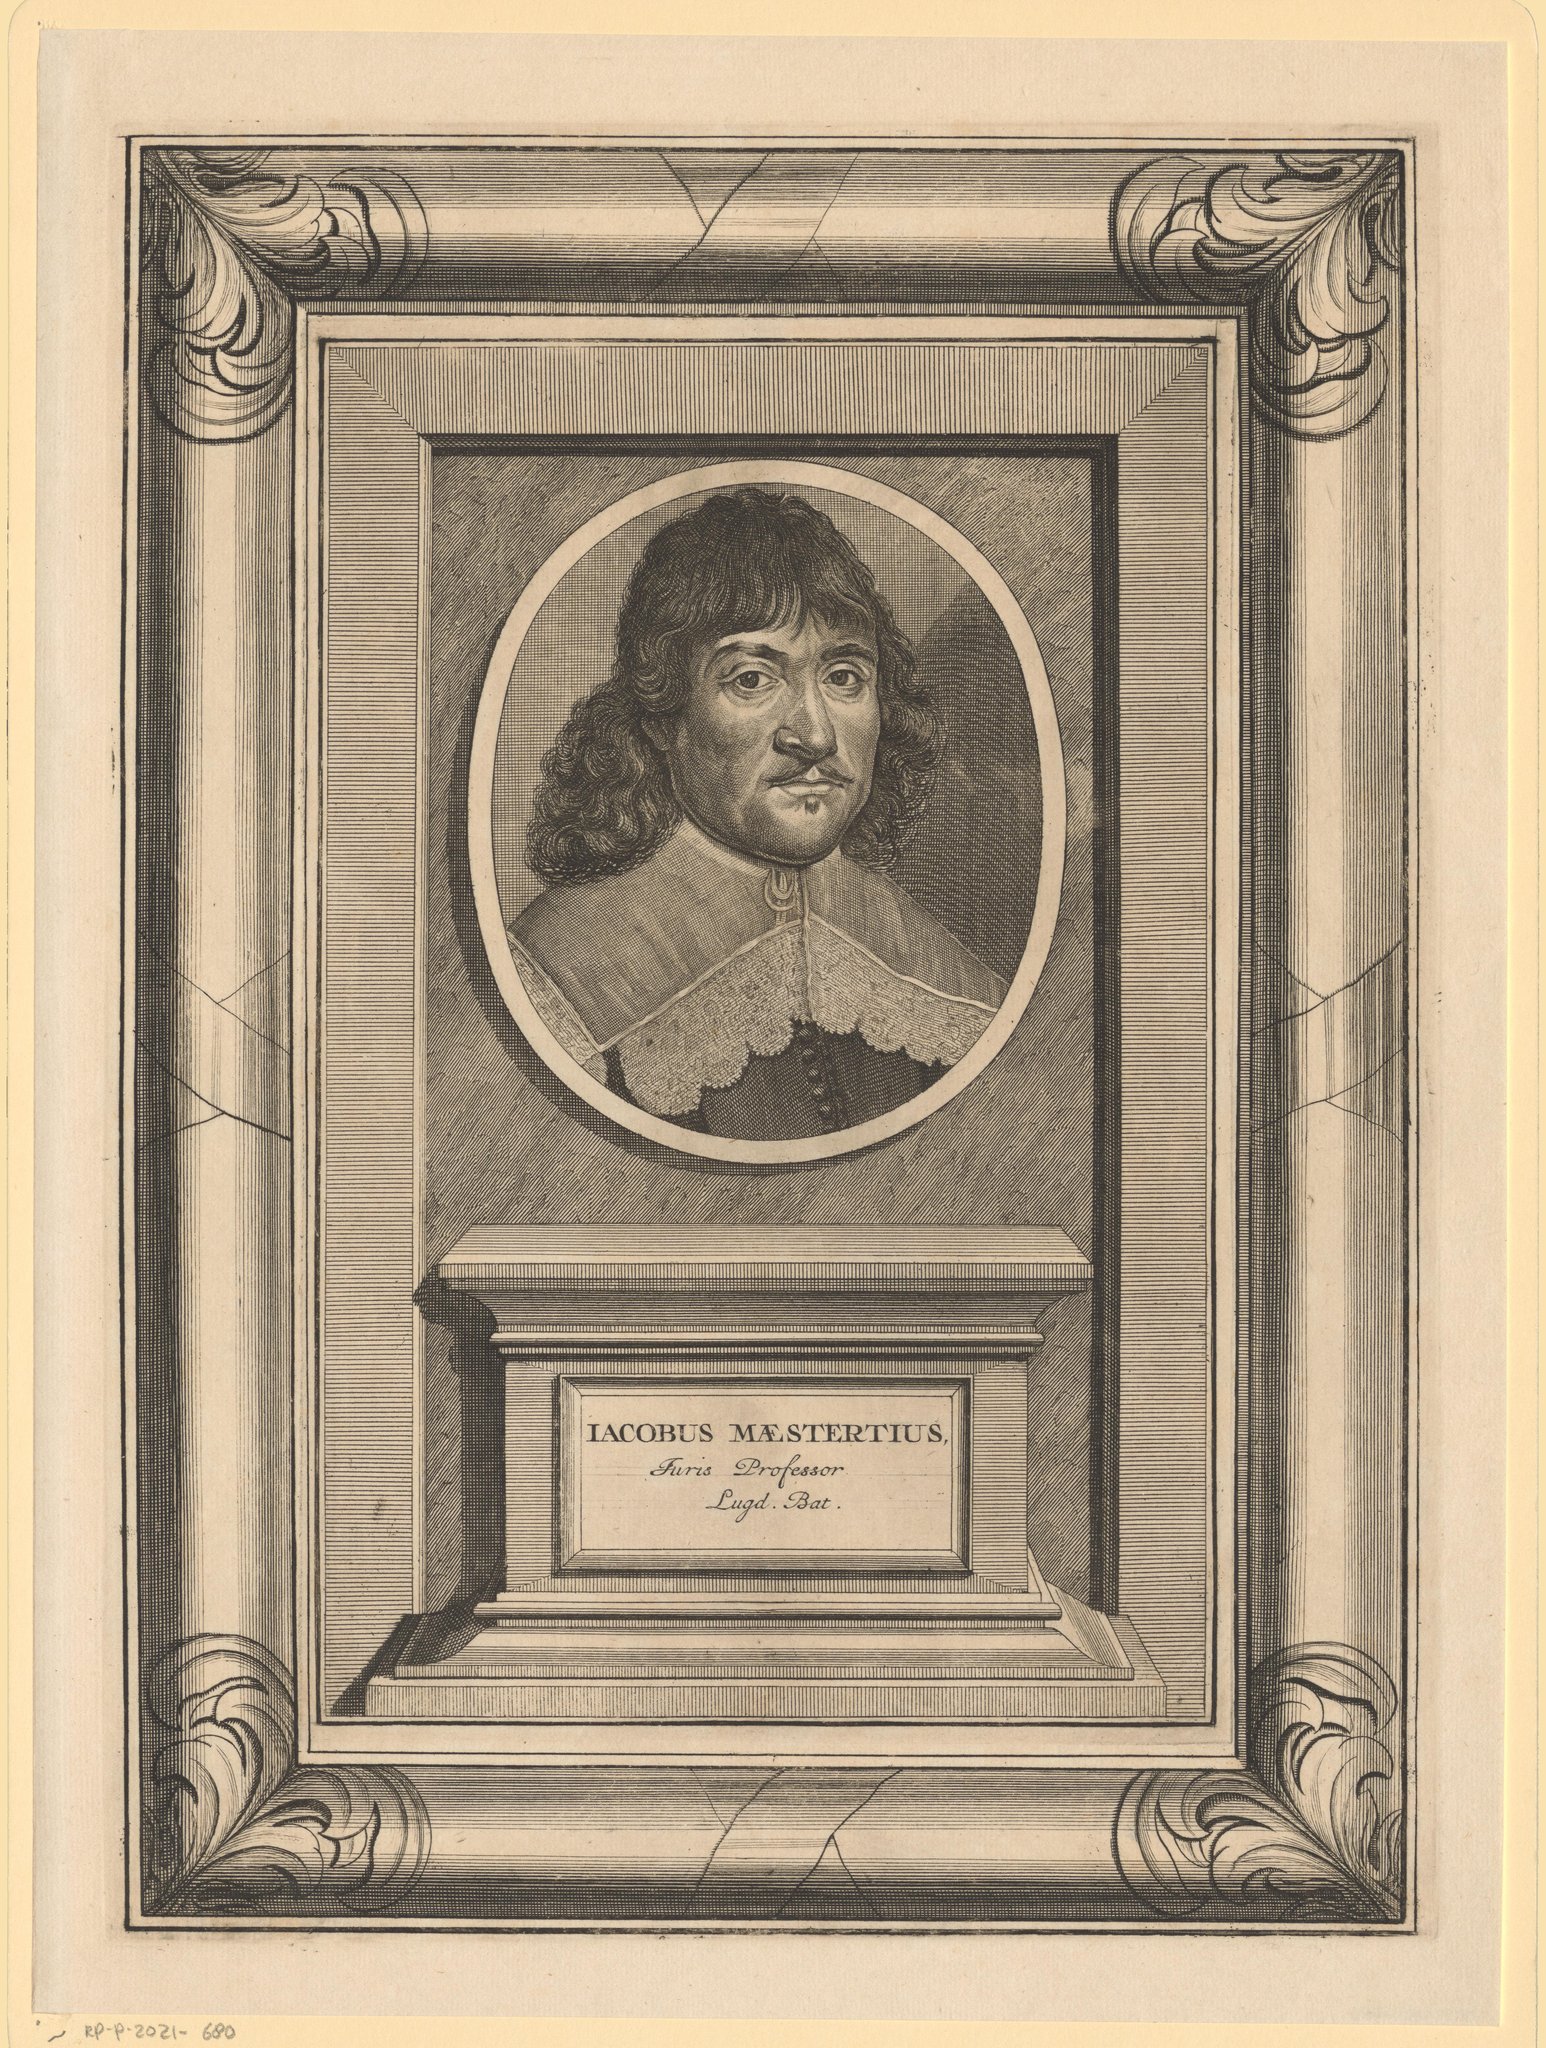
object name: print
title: Portret van Jacob Maestert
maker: Anonymous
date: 1642-1663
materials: paper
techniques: engraving, etching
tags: historical persons, lawyer, attorney at law